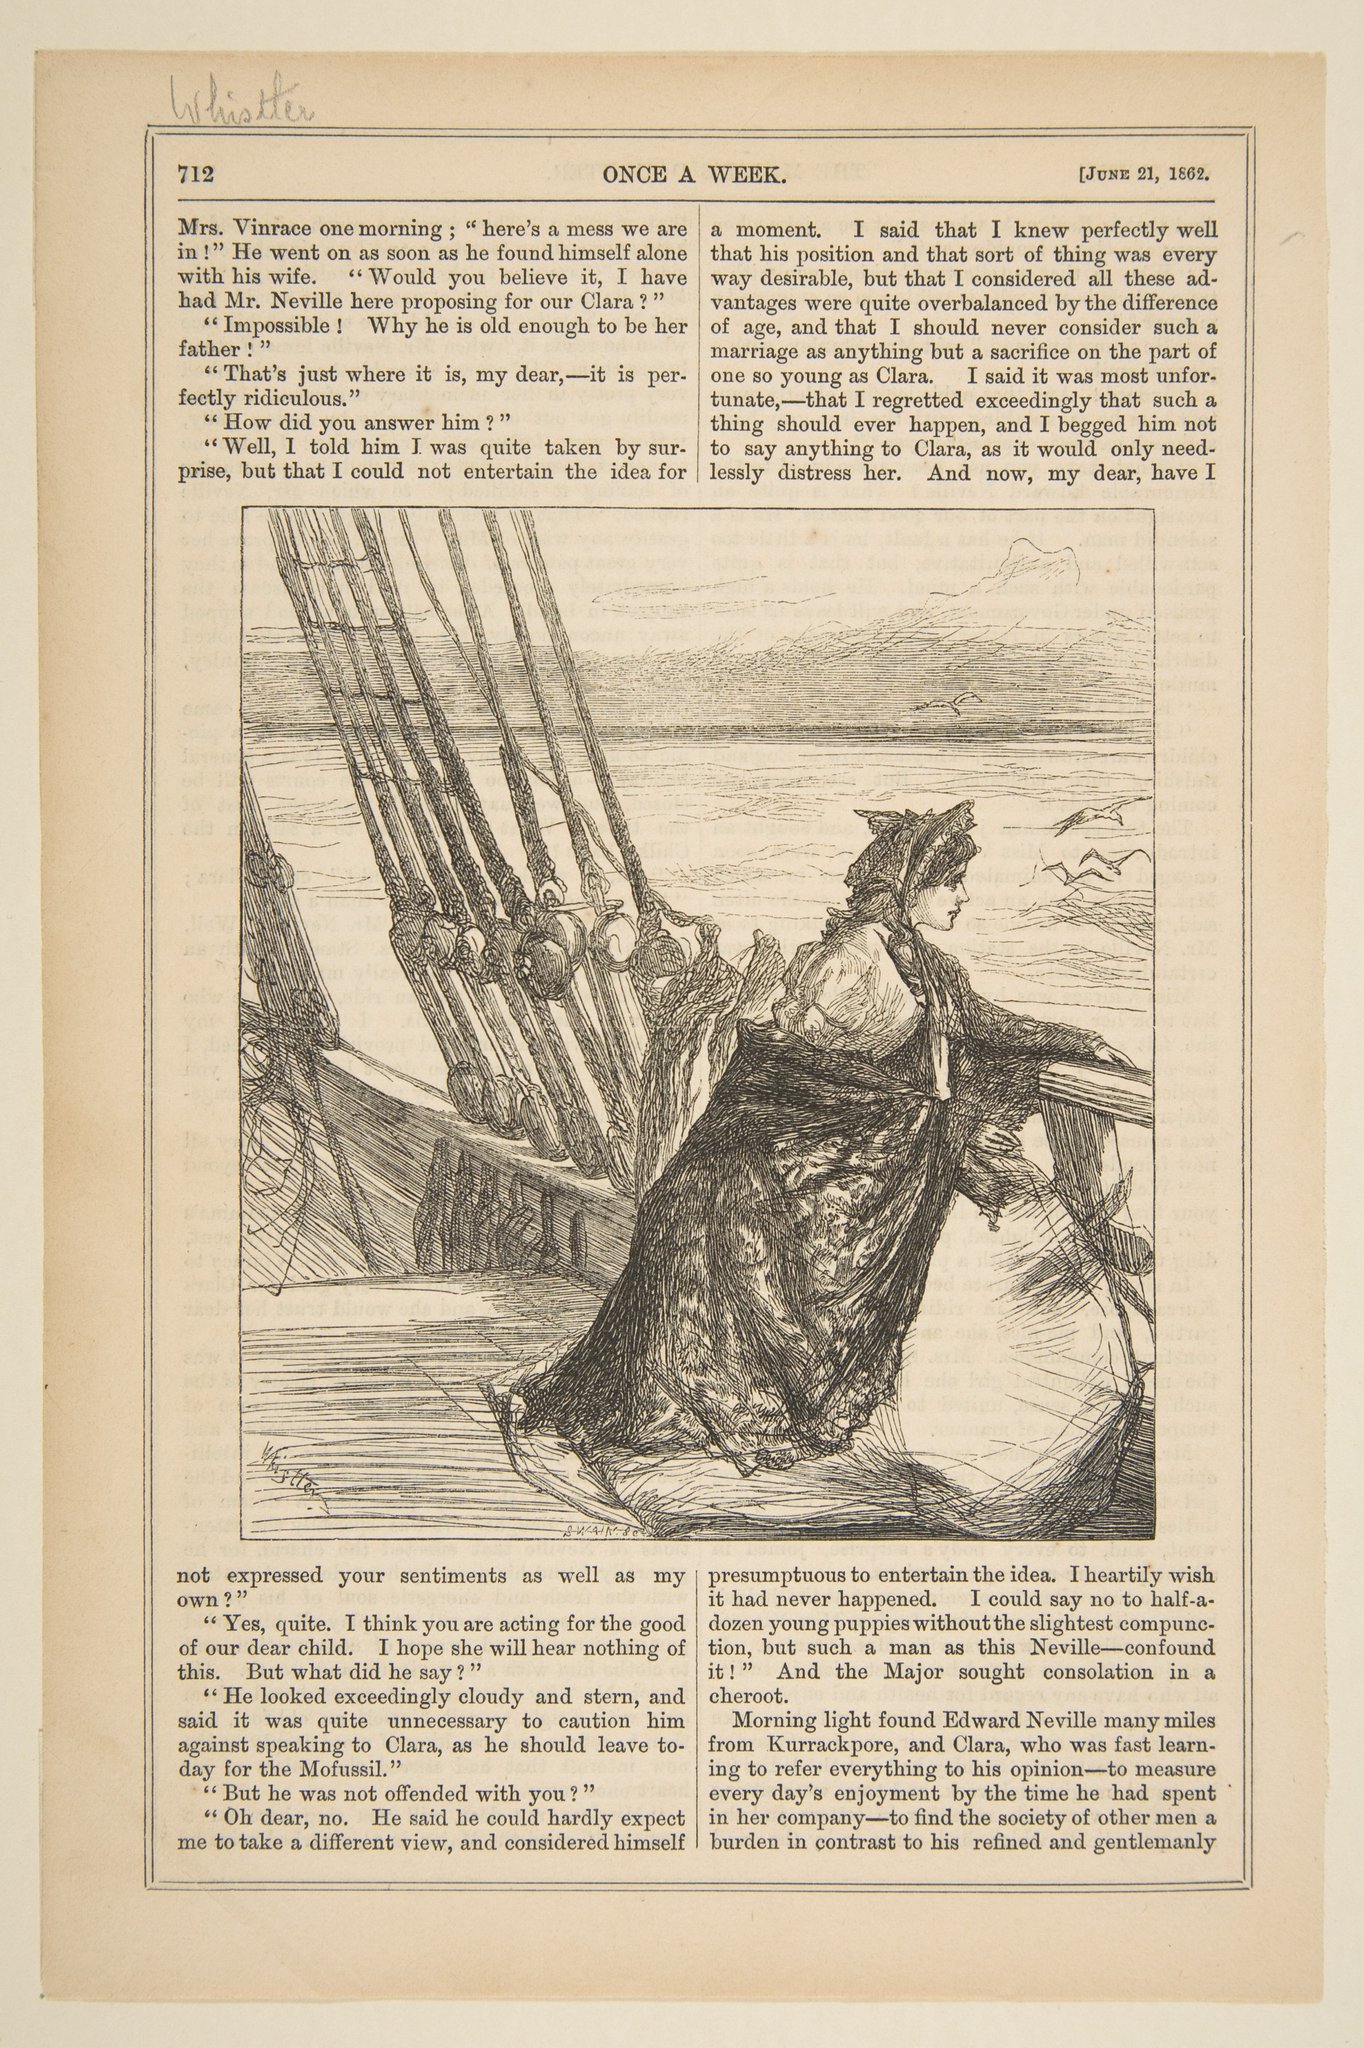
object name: print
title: The Major's Daughter (from "Once a Week," June 21, 1862)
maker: james mcneill whistler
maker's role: artist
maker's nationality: american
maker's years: 1834-1903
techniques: engraving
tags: women,ships